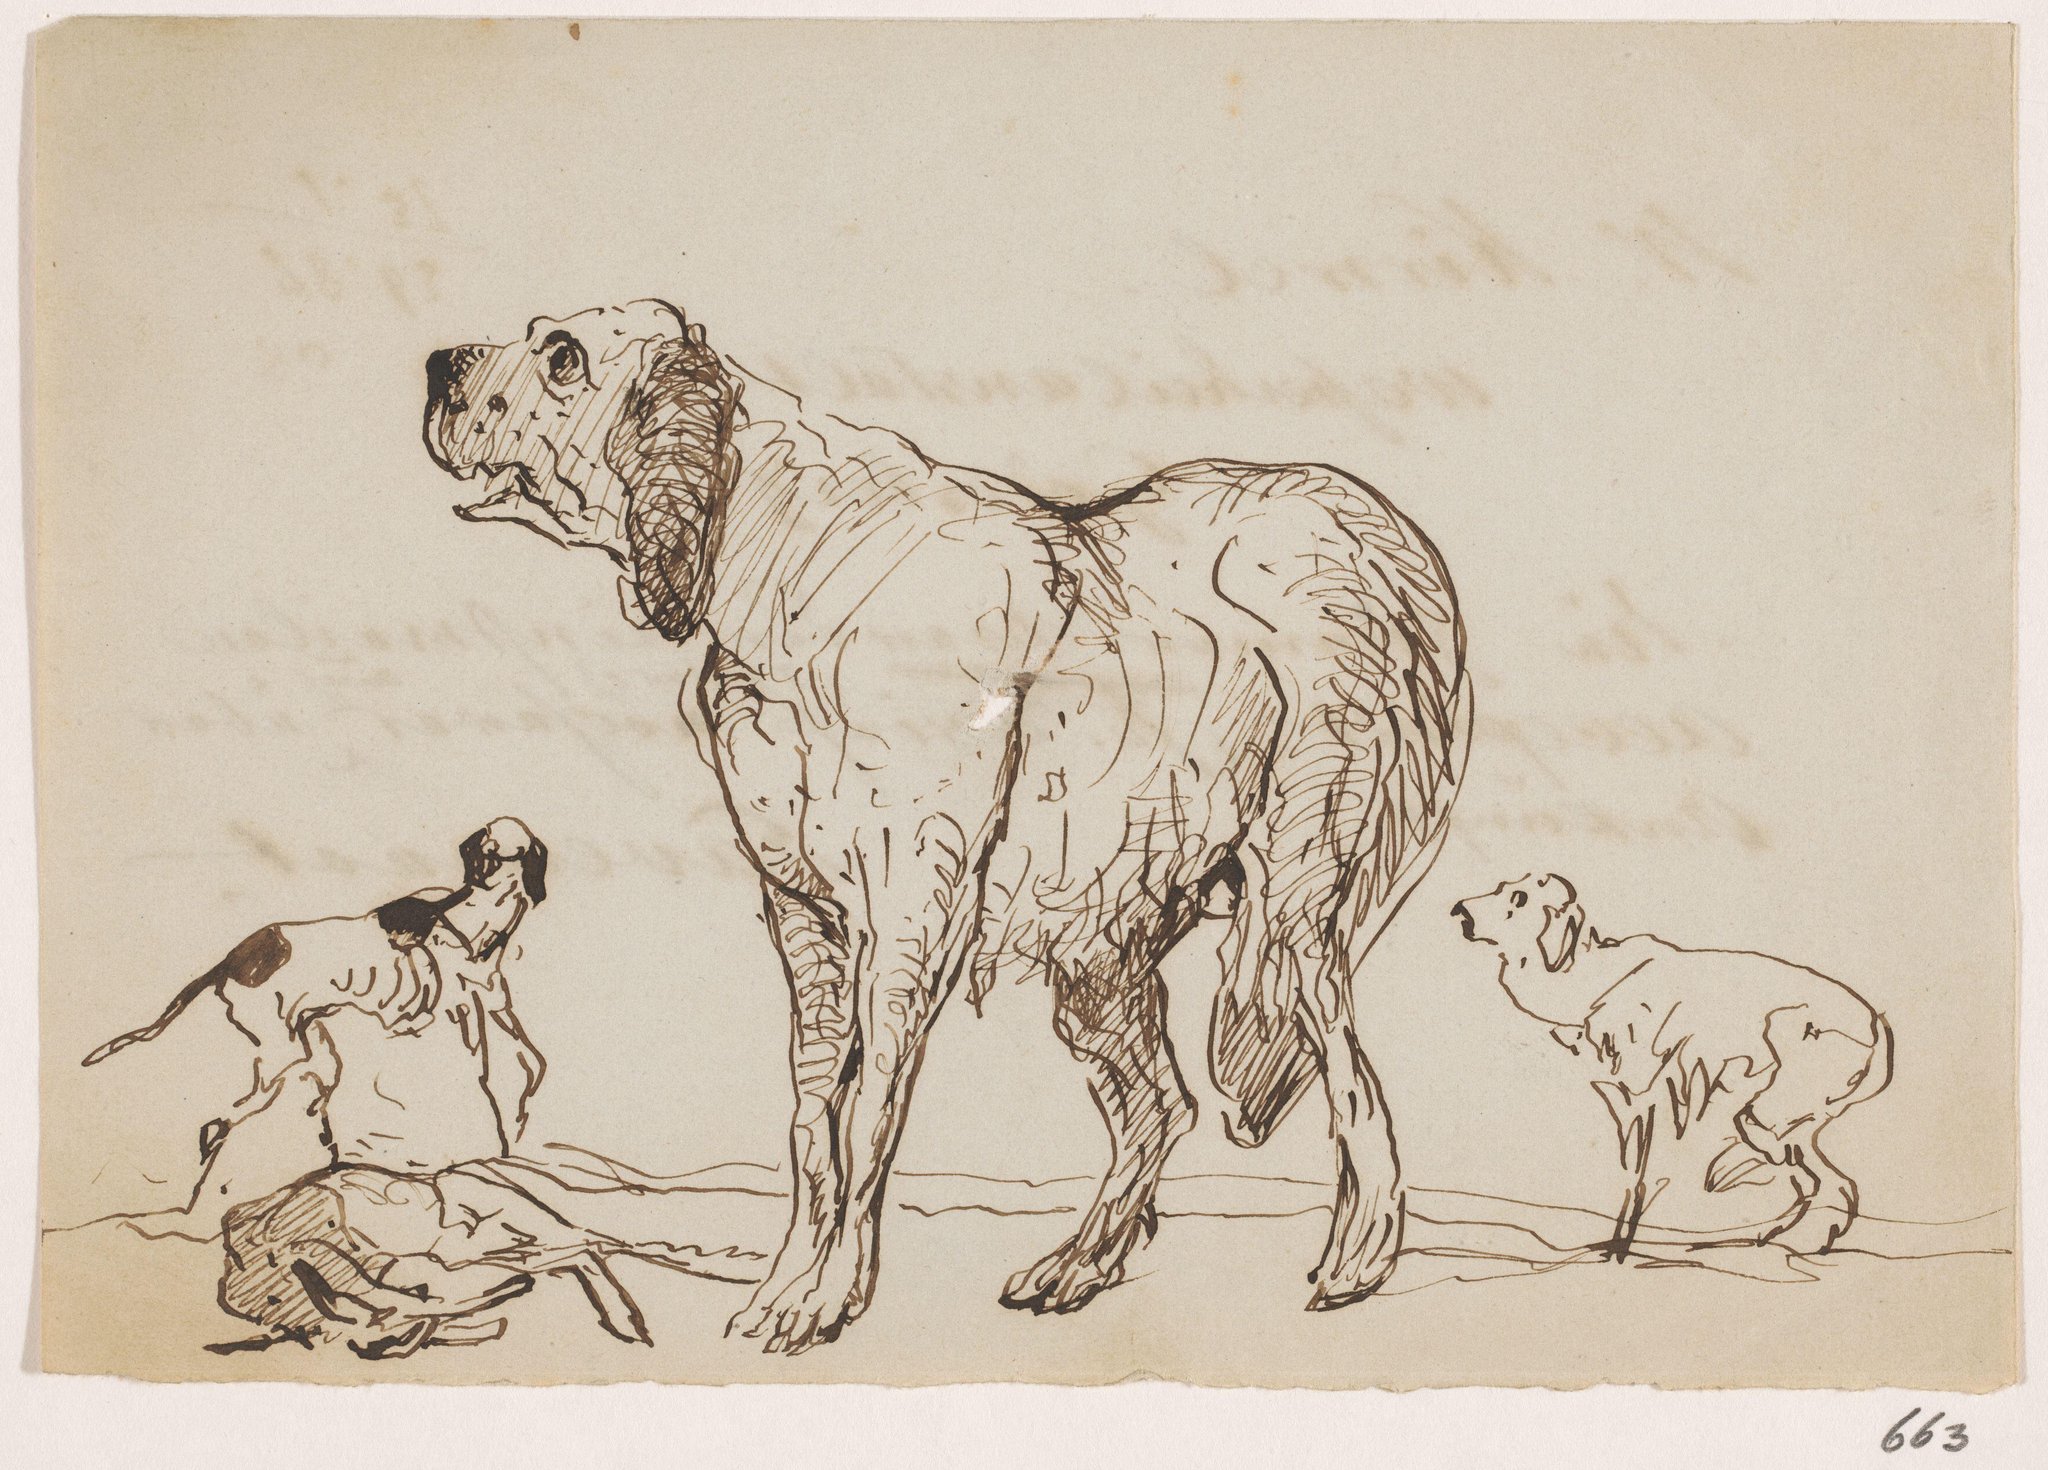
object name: drawing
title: Enkele honden bij een haas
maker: johannes tavenraat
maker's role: draughtsman, painter, print maker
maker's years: 1809-1881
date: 1840-1880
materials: ink, paper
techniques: pen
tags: rodents (with name) (+ dying animal; death of animal; dead animal), hunting dogs, dog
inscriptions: collector's mark: Lugt 2228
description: Enkele honden bij een haas. Getekend op de achterzijde van een briefje door J. Tavenraat.